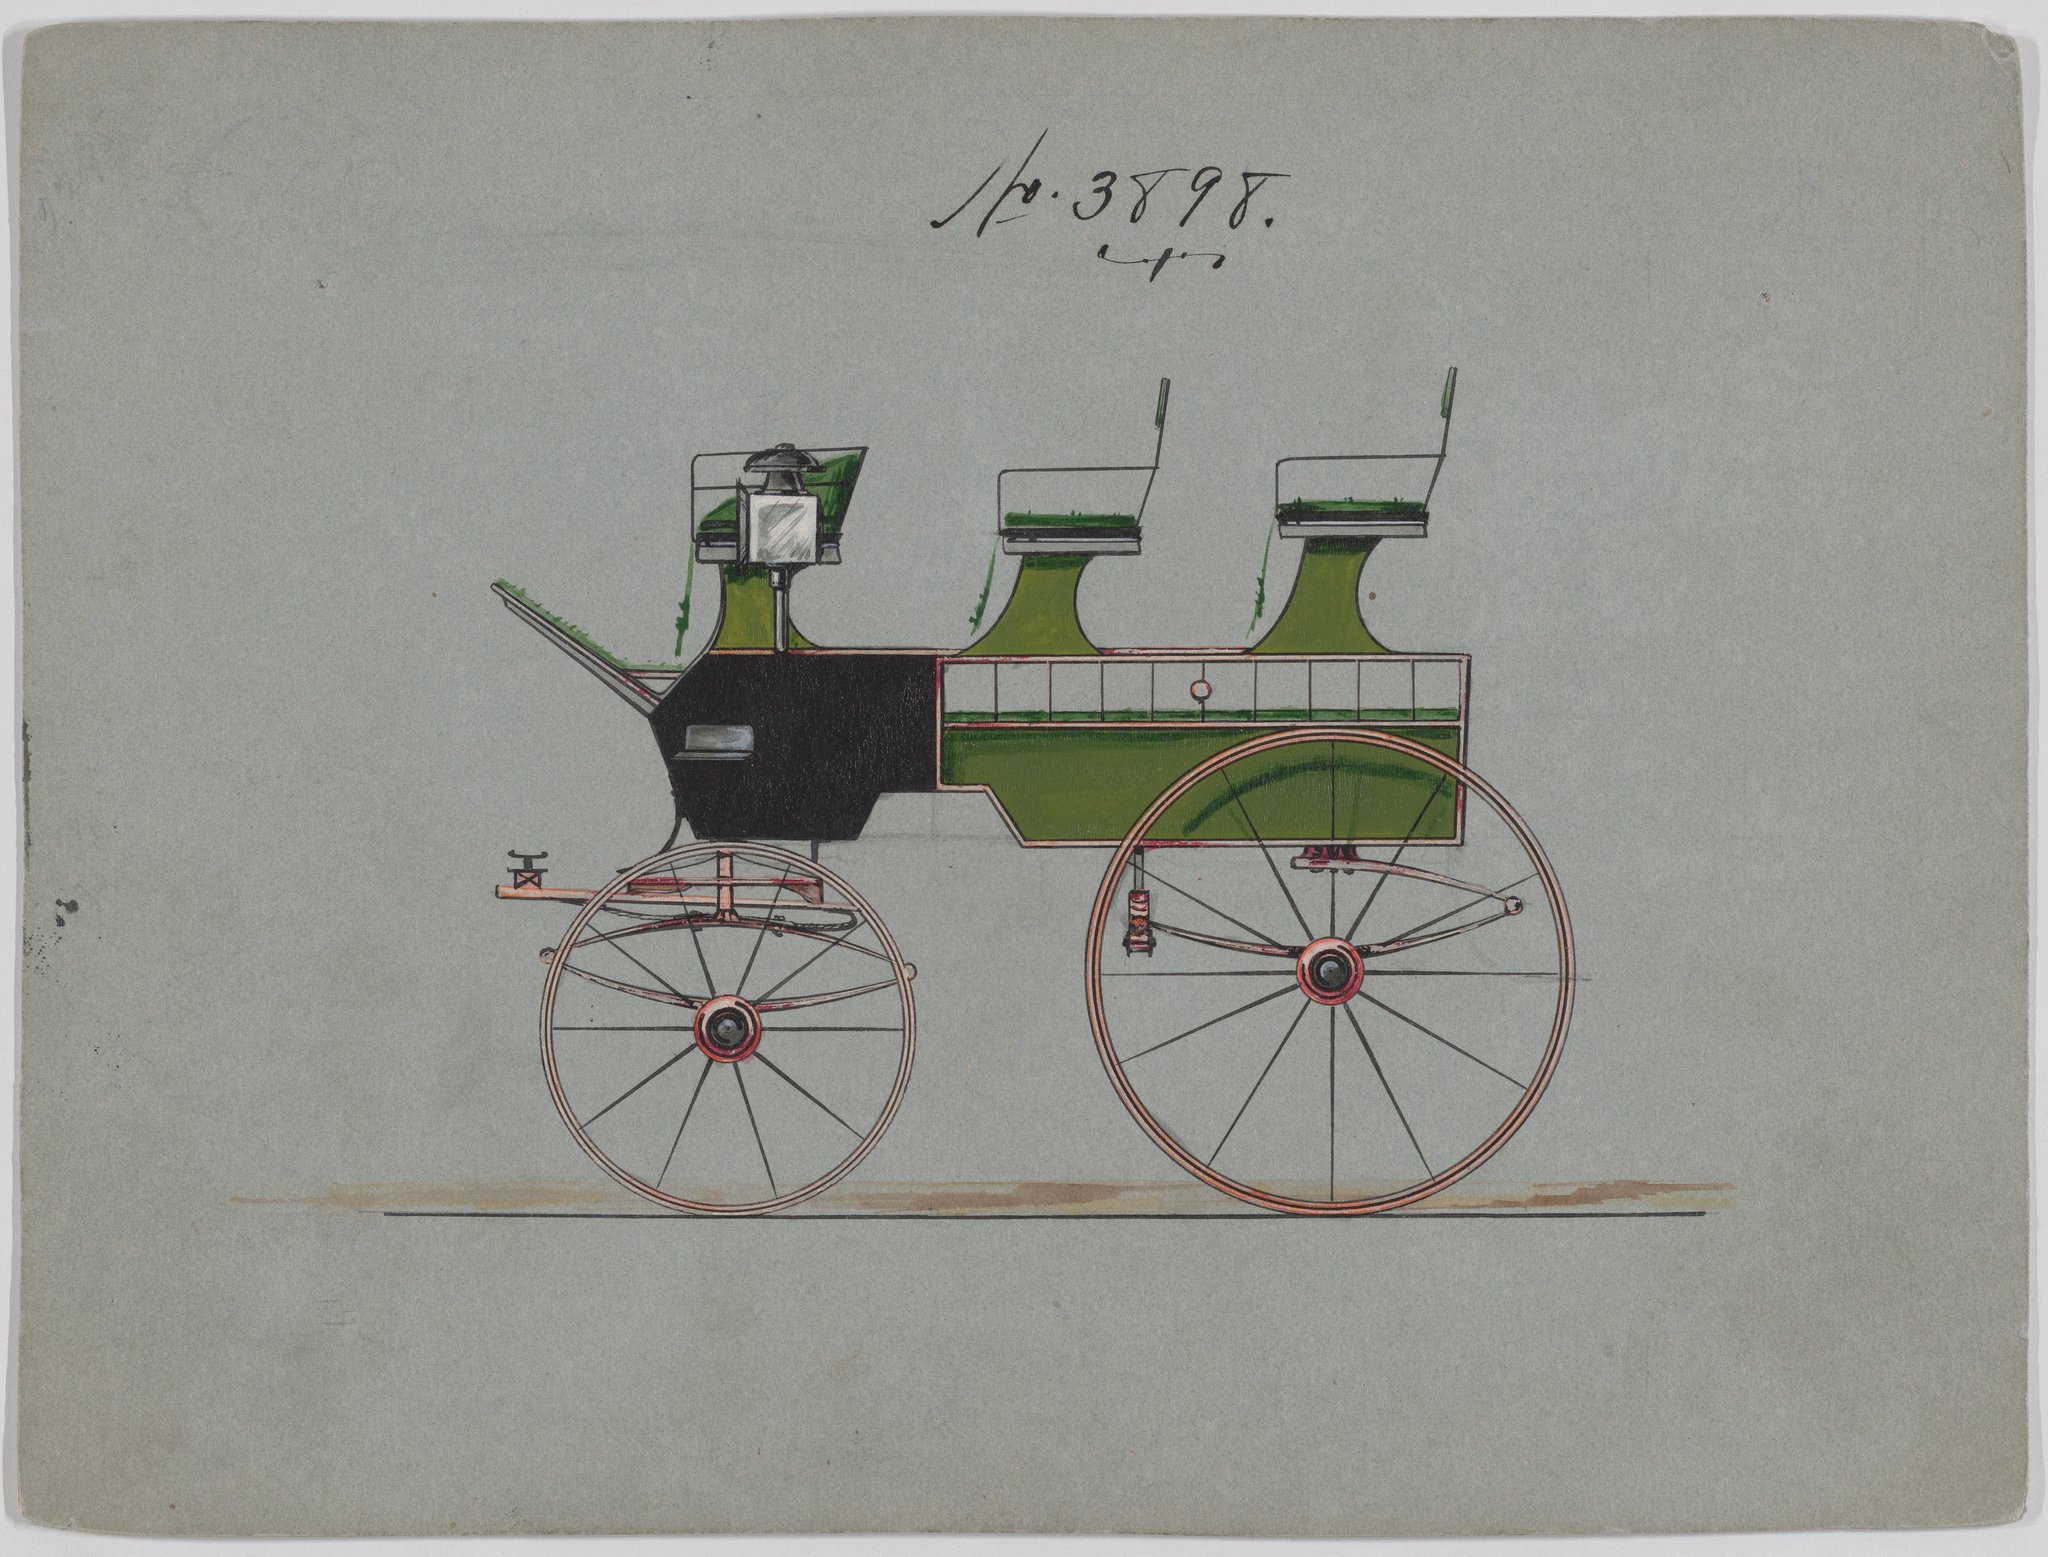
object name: drawing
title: Roof Seat Break #3898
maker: brewster & co.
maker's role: manufacturer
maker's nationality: american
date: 1884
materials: gouache, gum arabic, ink, watercolor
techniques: pen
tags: carriages